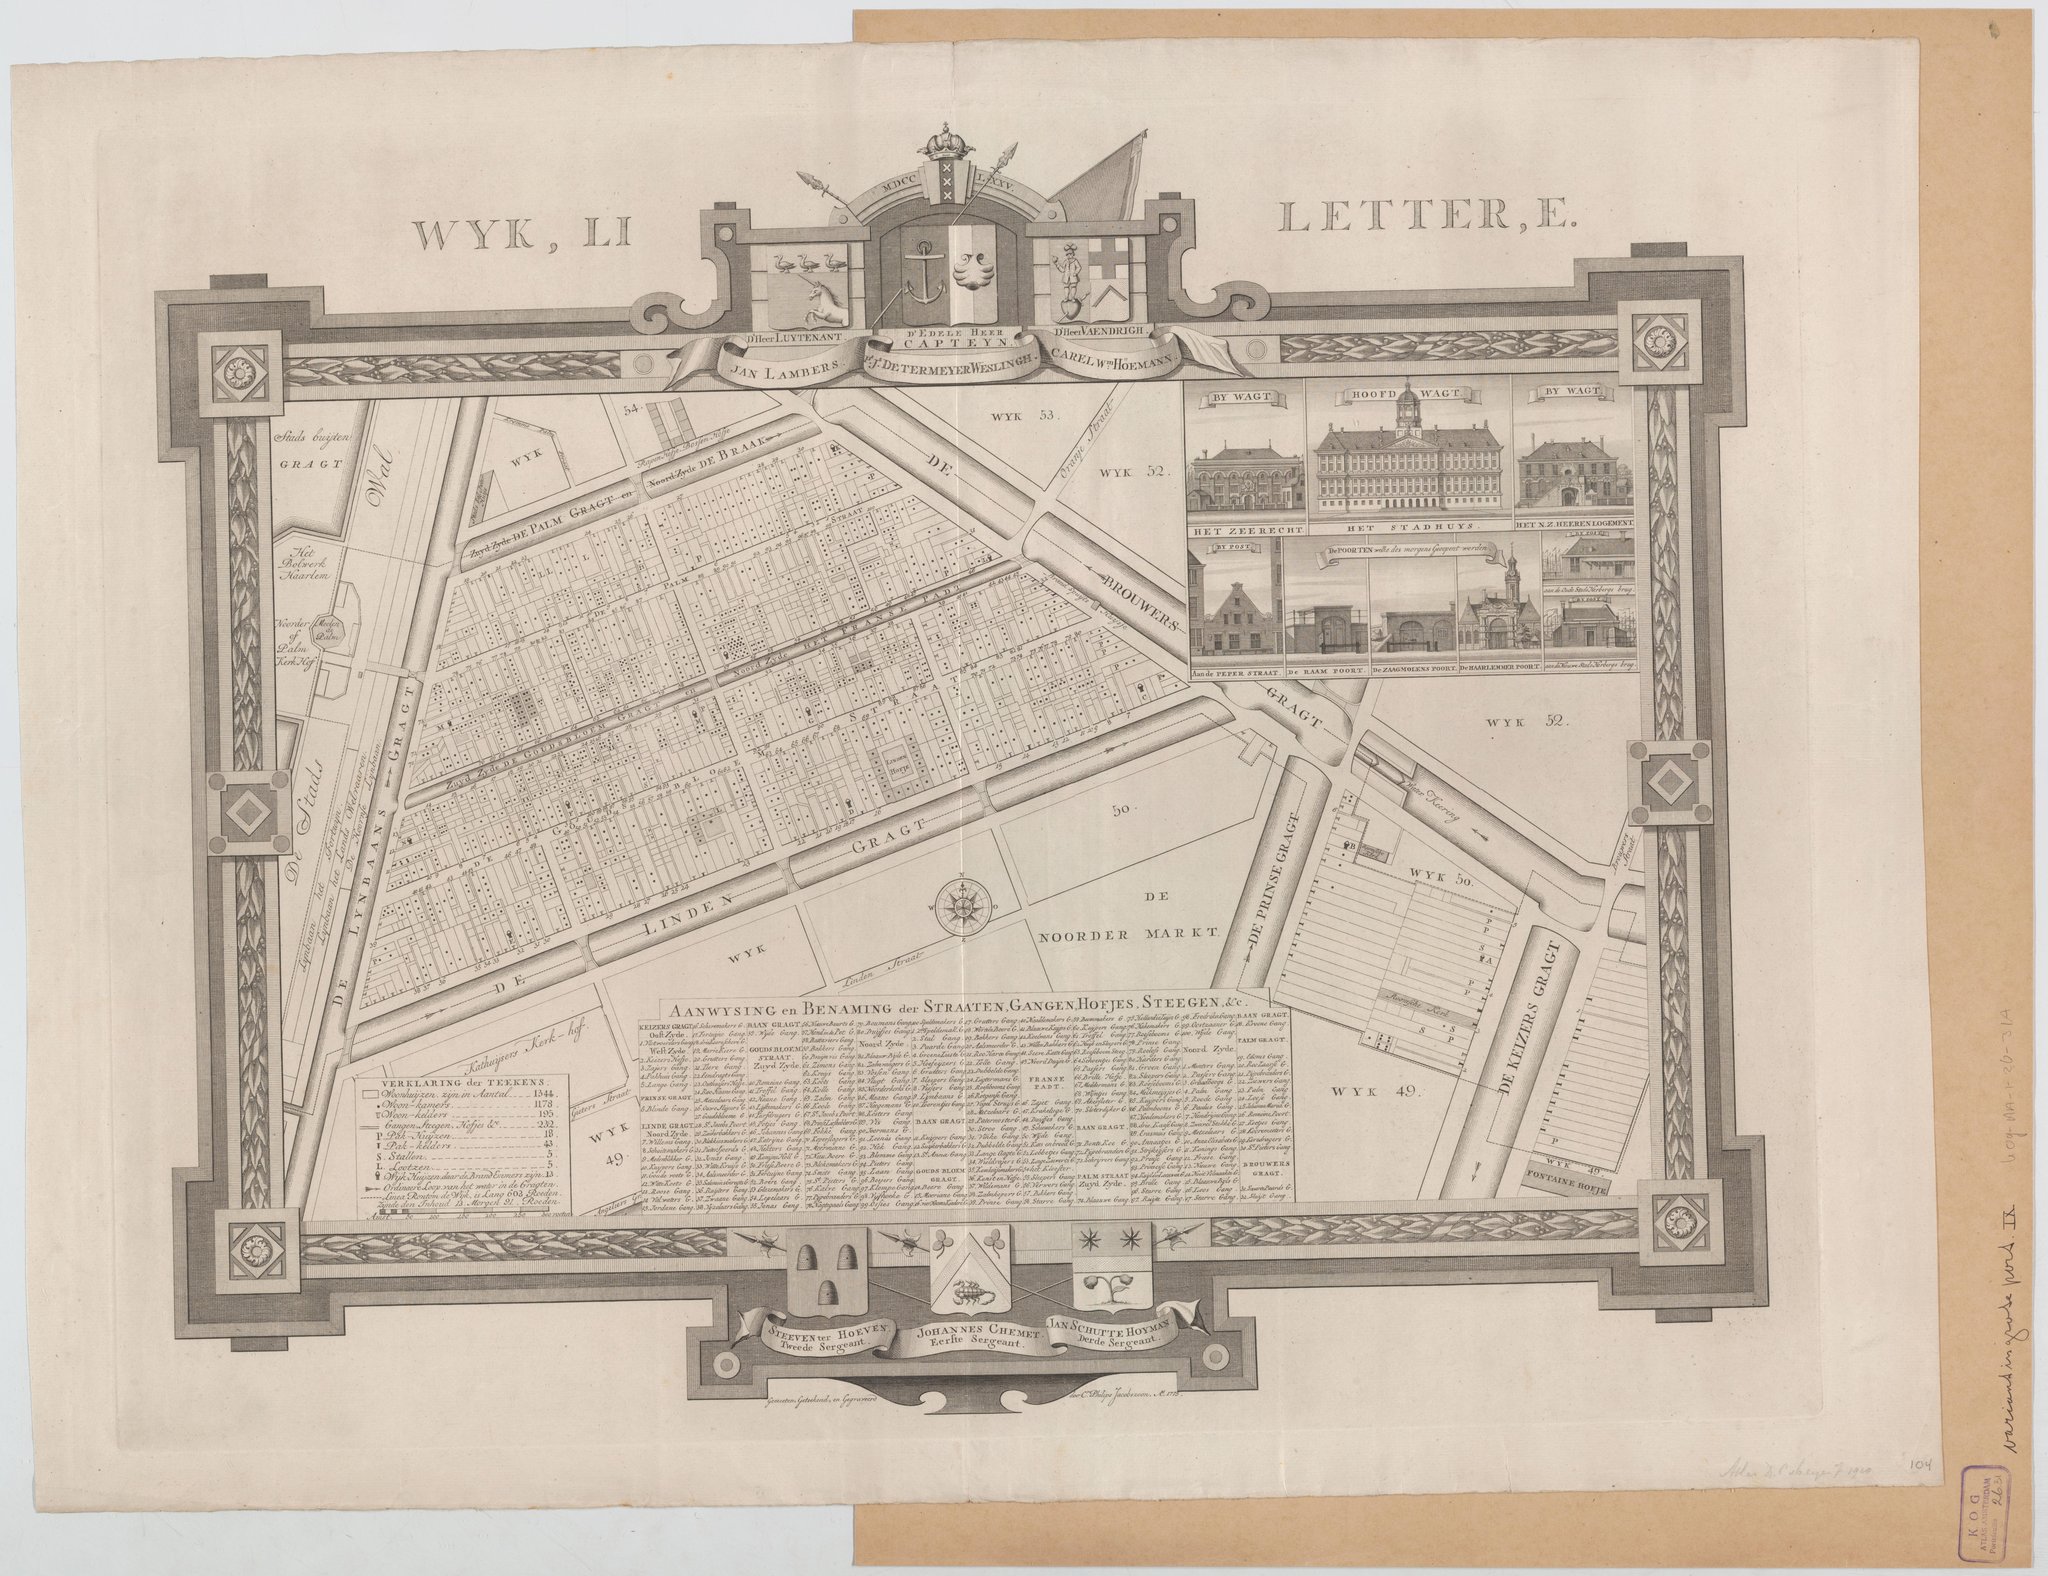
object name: area plan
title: Wyk, LI / Letter, E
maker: caspar jacobsz. philips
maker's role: draughtsman, print maker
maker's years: 1732-1789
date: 1775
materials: paper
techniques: engraving, etching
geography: amsterdam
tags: coat of arms (as symbol of the state, etc.) (+ city; municipal), maps of cities, armorial bearing, heraldry, amsterdam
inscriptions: collector's mark: Lugt 1641b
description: Onderwerpsrubriek binnen de Atlas Amsterdam: Schutterswijkkaarten.